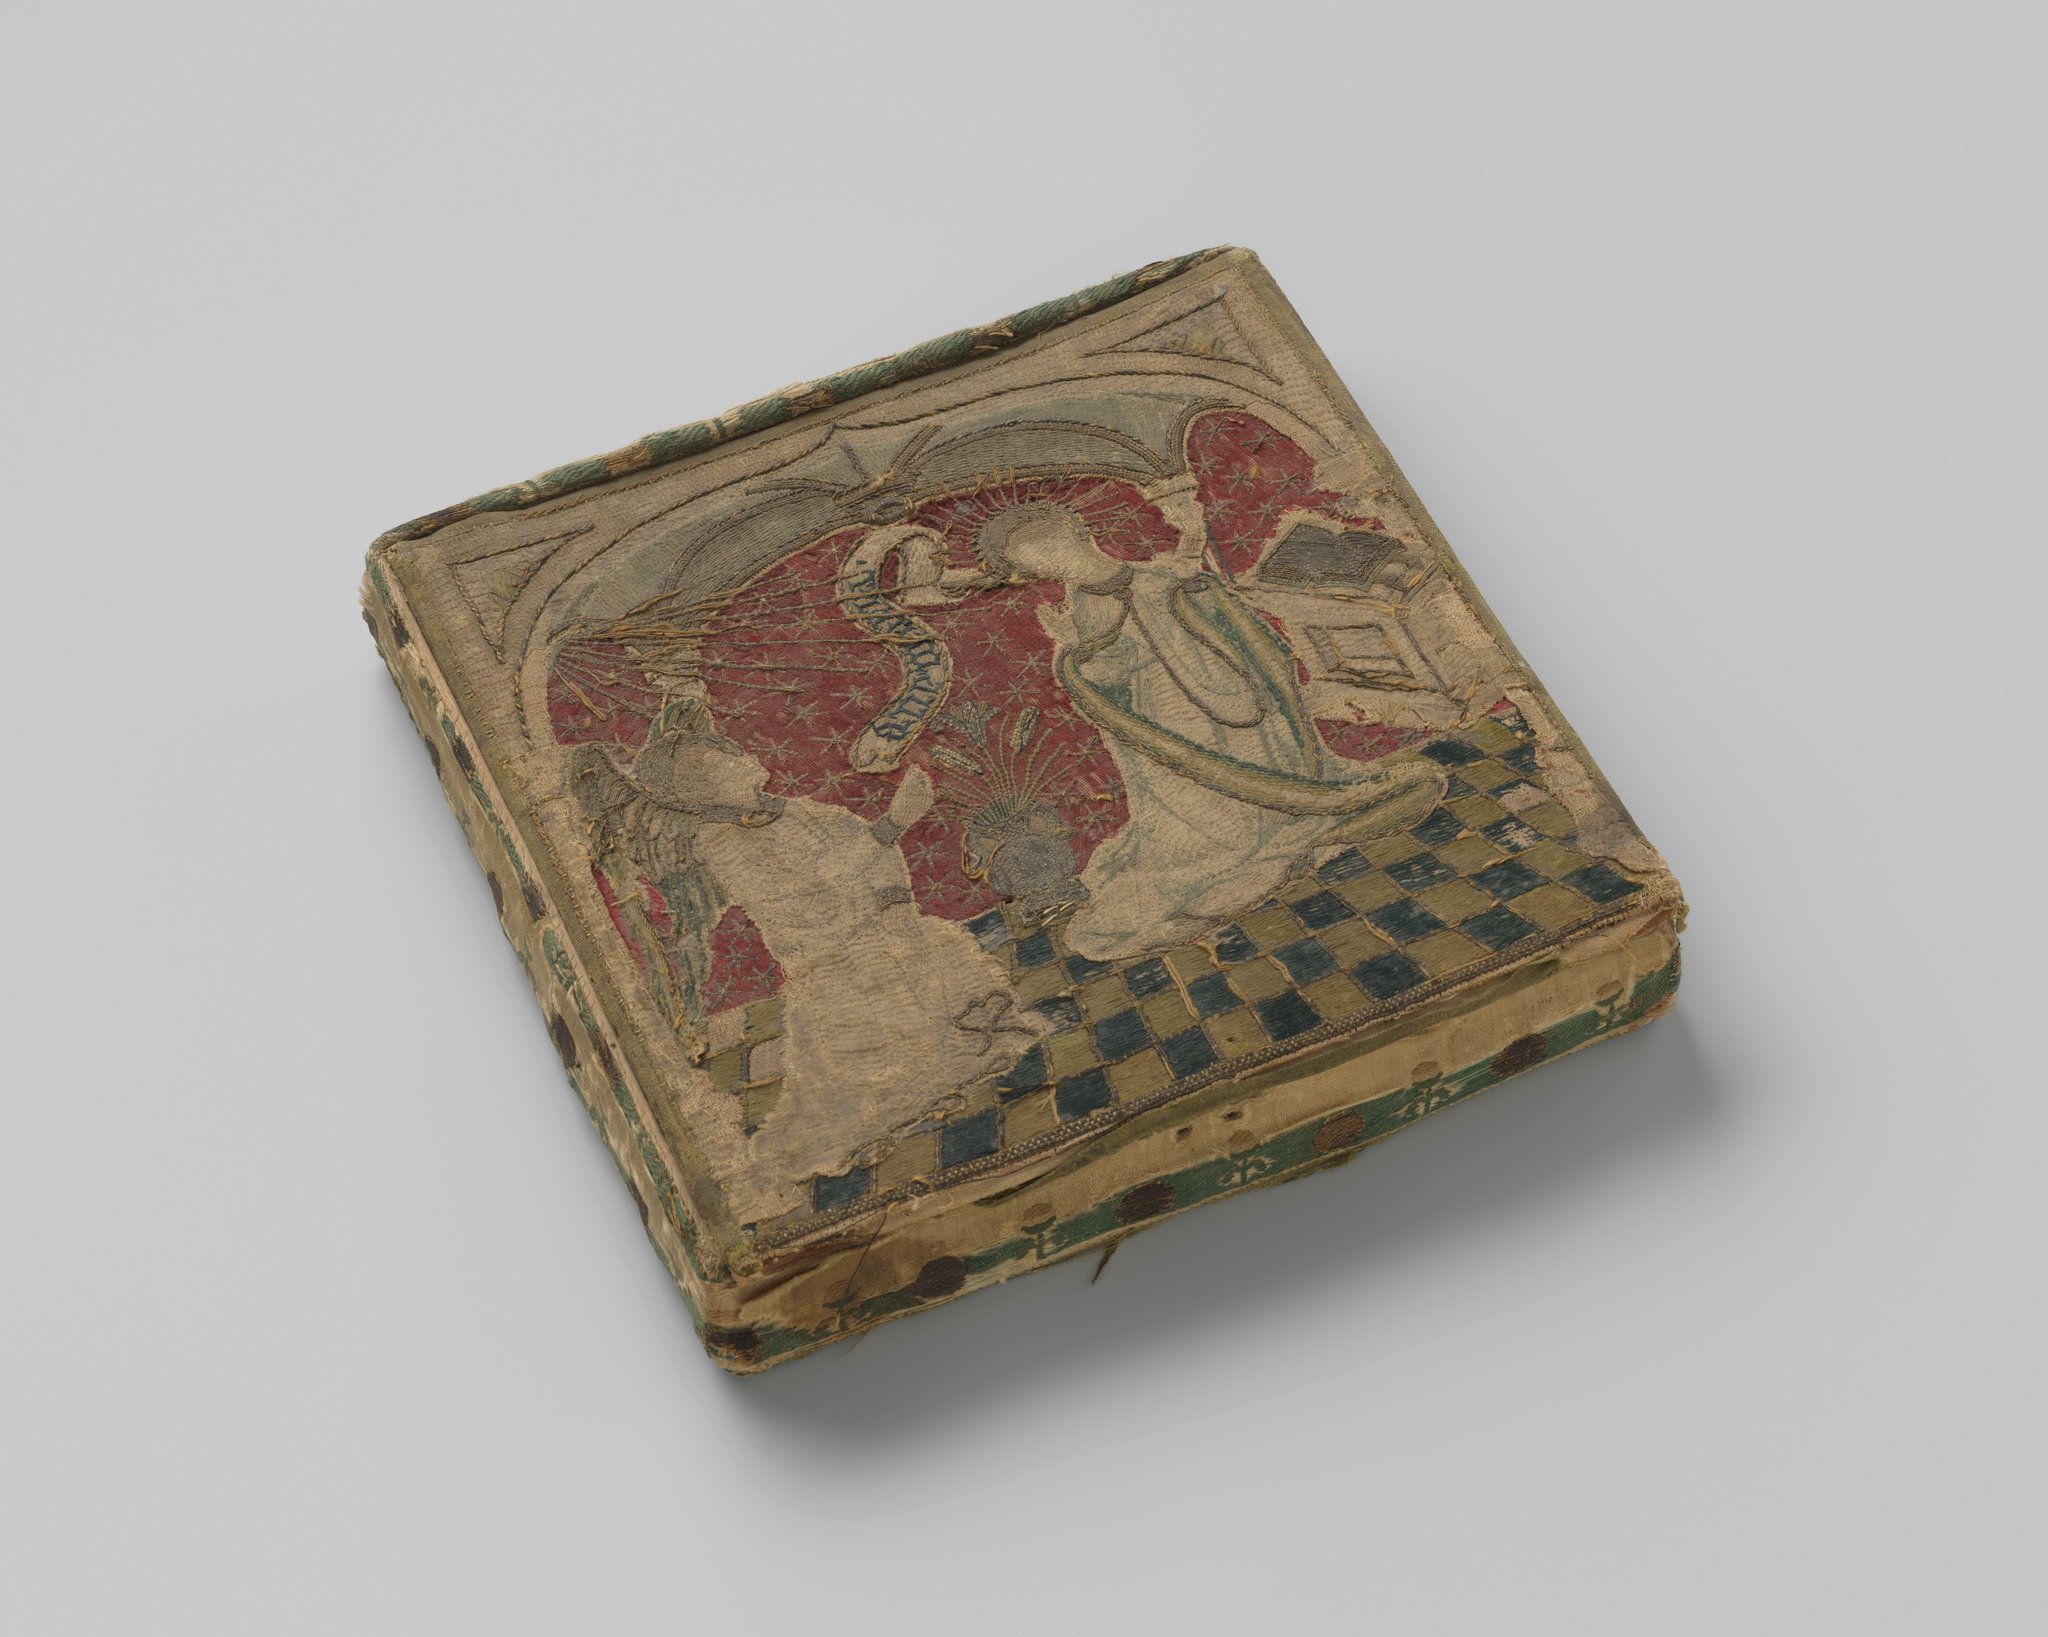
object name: corporal case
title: Corporaledoos met borduurwerk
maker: Anonymous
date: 1475-1525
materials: gold thread, silk, velvet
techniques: brocade, damask, embroidered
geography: england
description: Corporal box. The Annunciation. Embroidery in silk and gold thread. England or Southern Netherlands, c. 1480 - 1500. Gift of Jonkheer D.C. Röell, 1959.